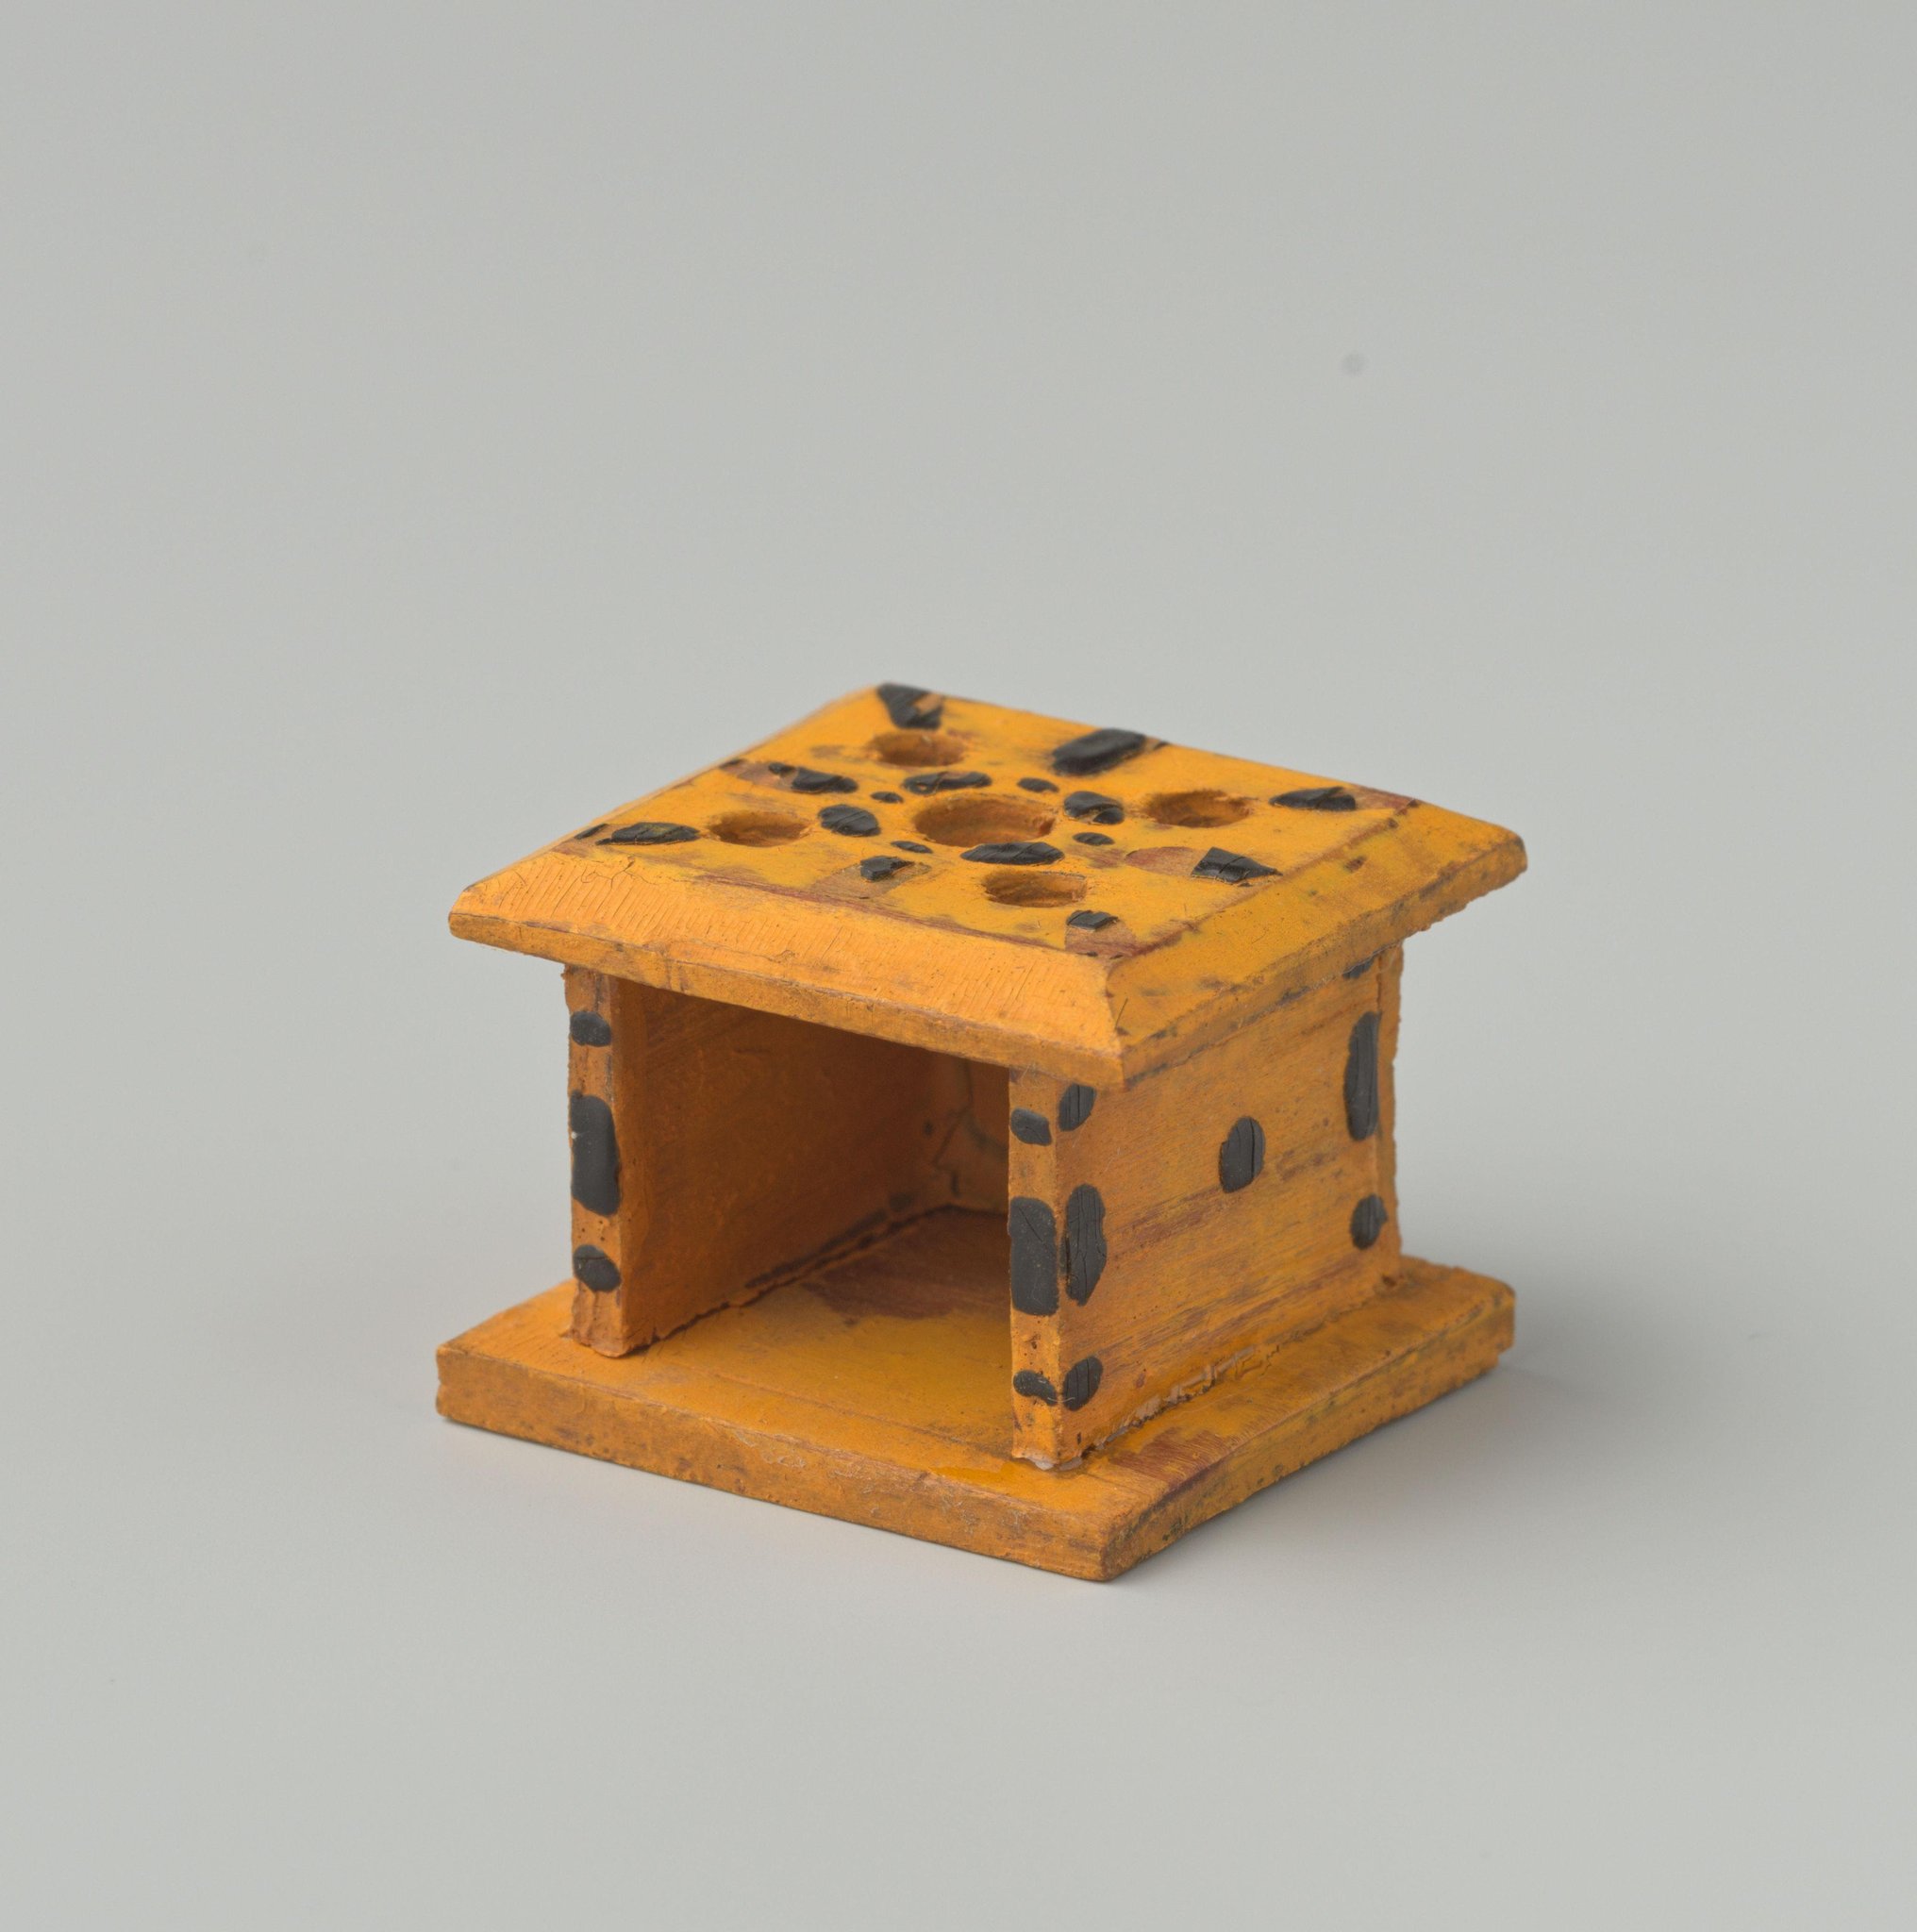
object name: voetstoof, stoof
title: Stoof, geel van kleur, versierd met zwarte stippen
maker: Anonymous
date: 1676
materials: without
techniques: without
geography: amsterdam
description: Stoof van without, vierkant van vorm. De geel gekleurde stoof is versierd met zwarte stippen. In de voetenplank zitten vijf gaten.